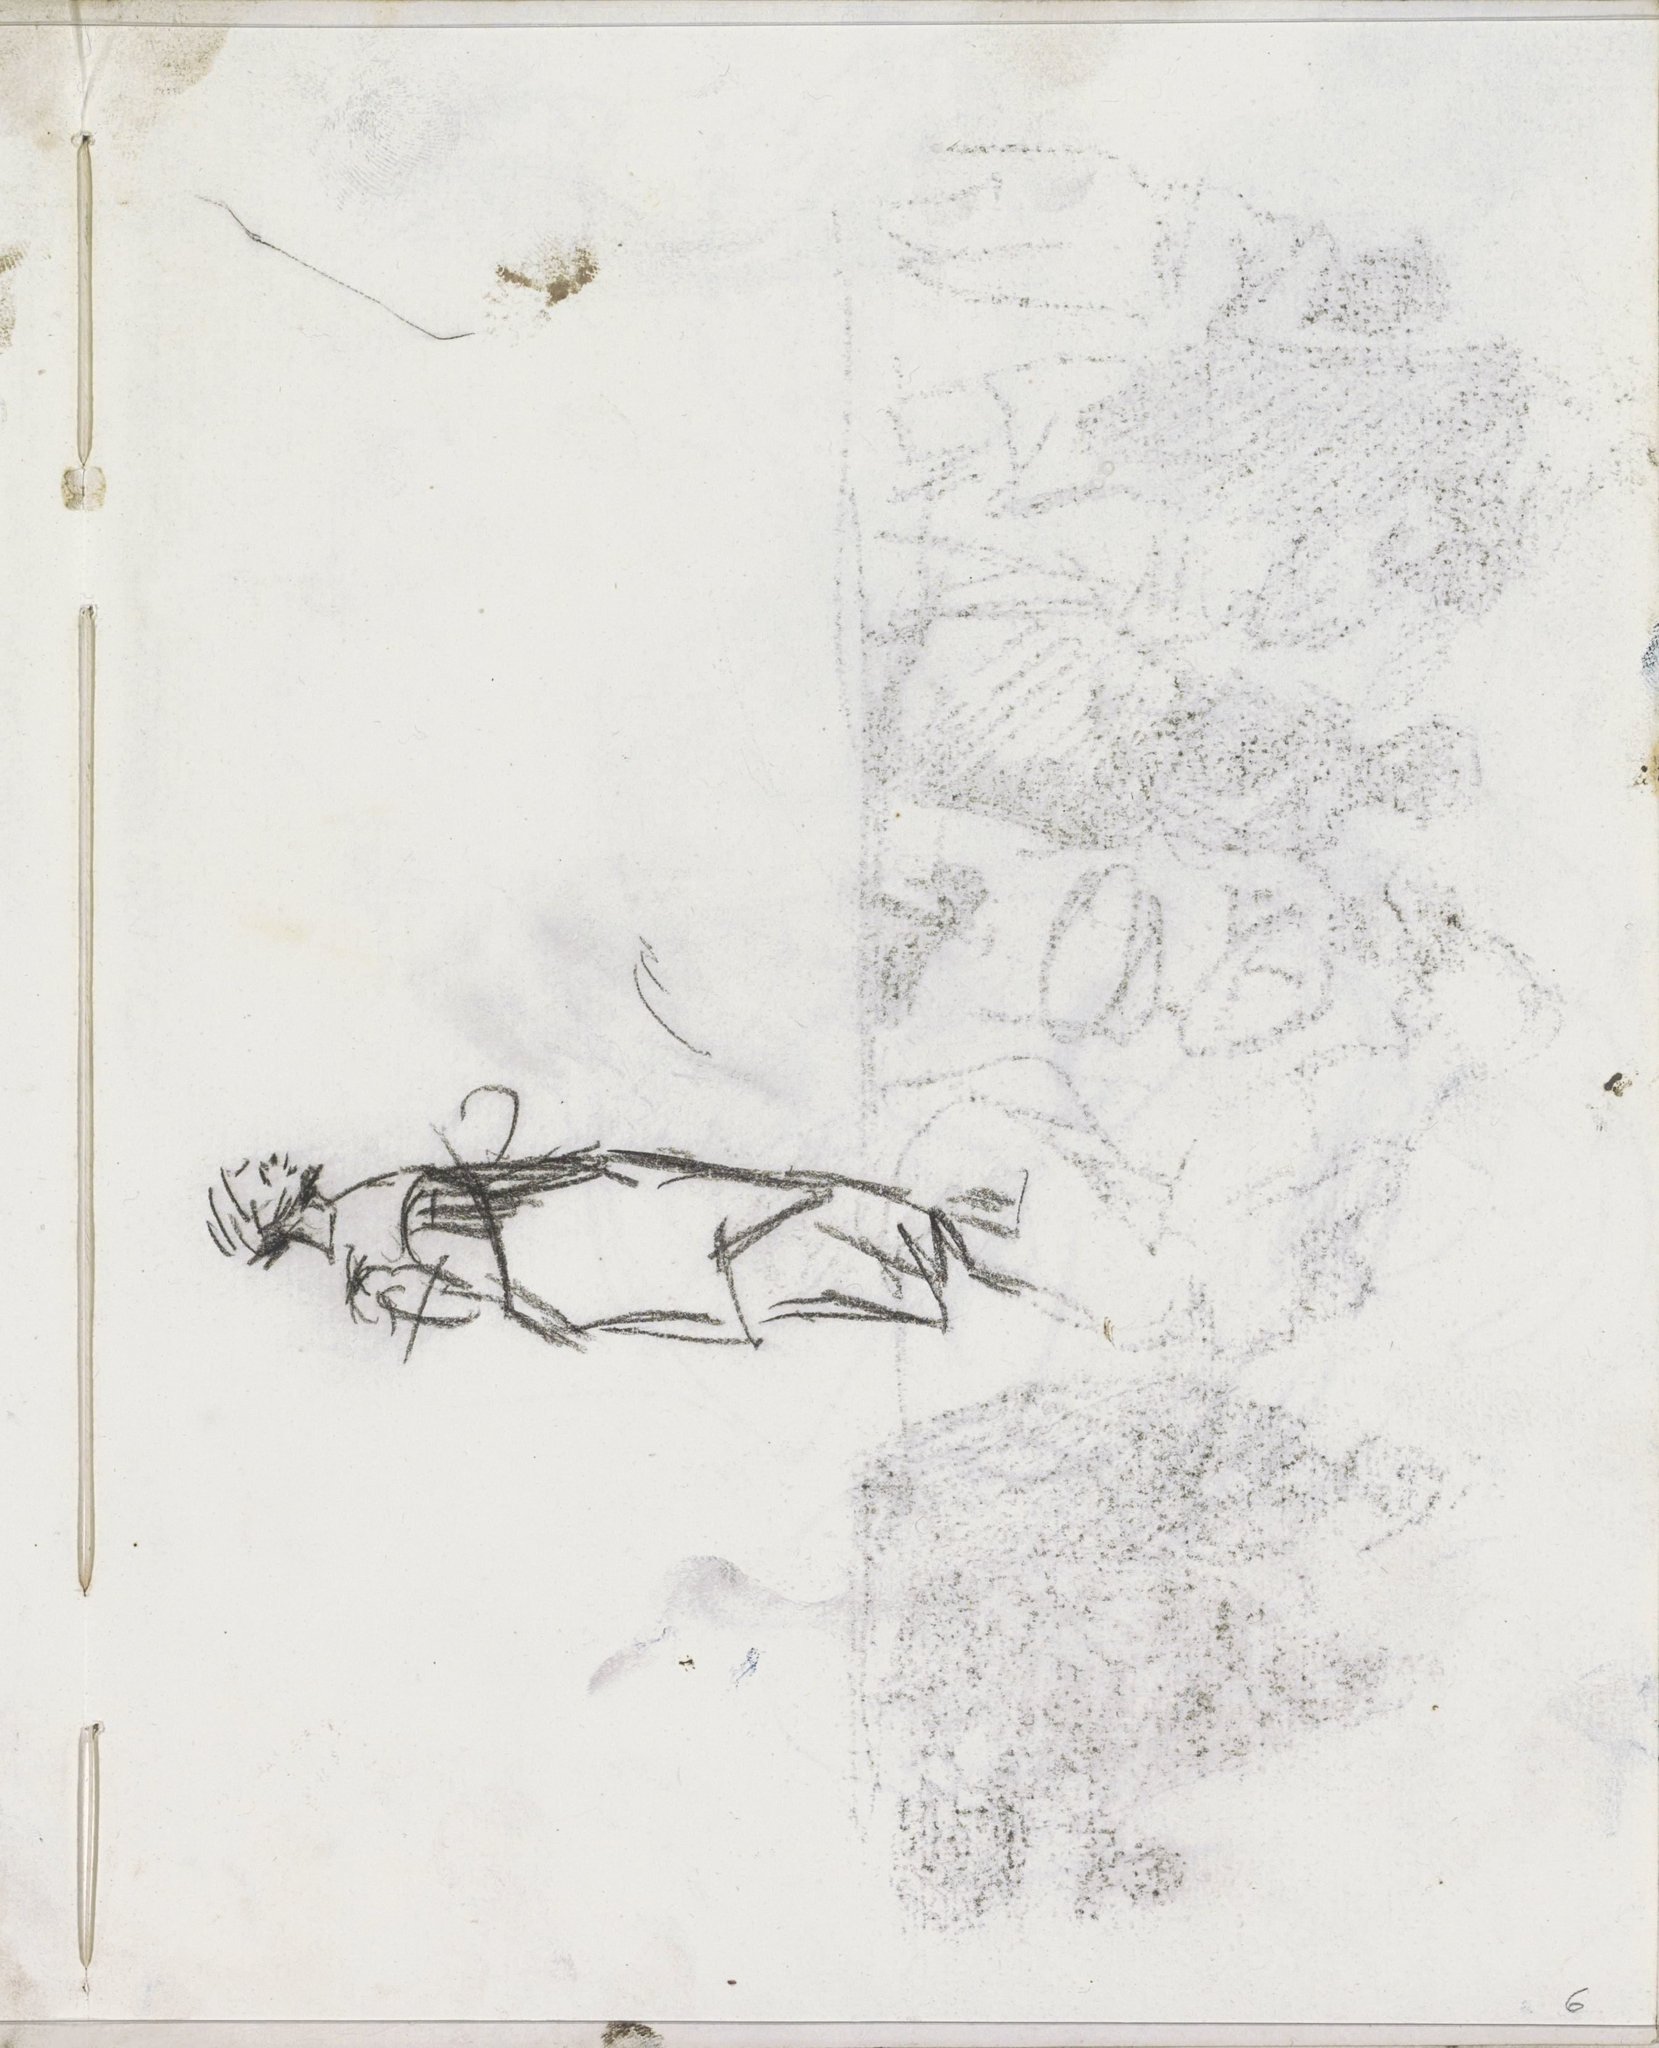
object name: sketchbook leaf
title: Staande figuur, in profiel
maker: isaac israels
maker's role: draughtsman, painter, print maker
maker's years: 1865-1934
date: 1875-1934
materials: chalk, paper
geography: the hague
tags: standing figure (+ sideview, profile)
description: Mogelijk een man. Blad 6 recto uit schetsboek XIII met 25 bladen.